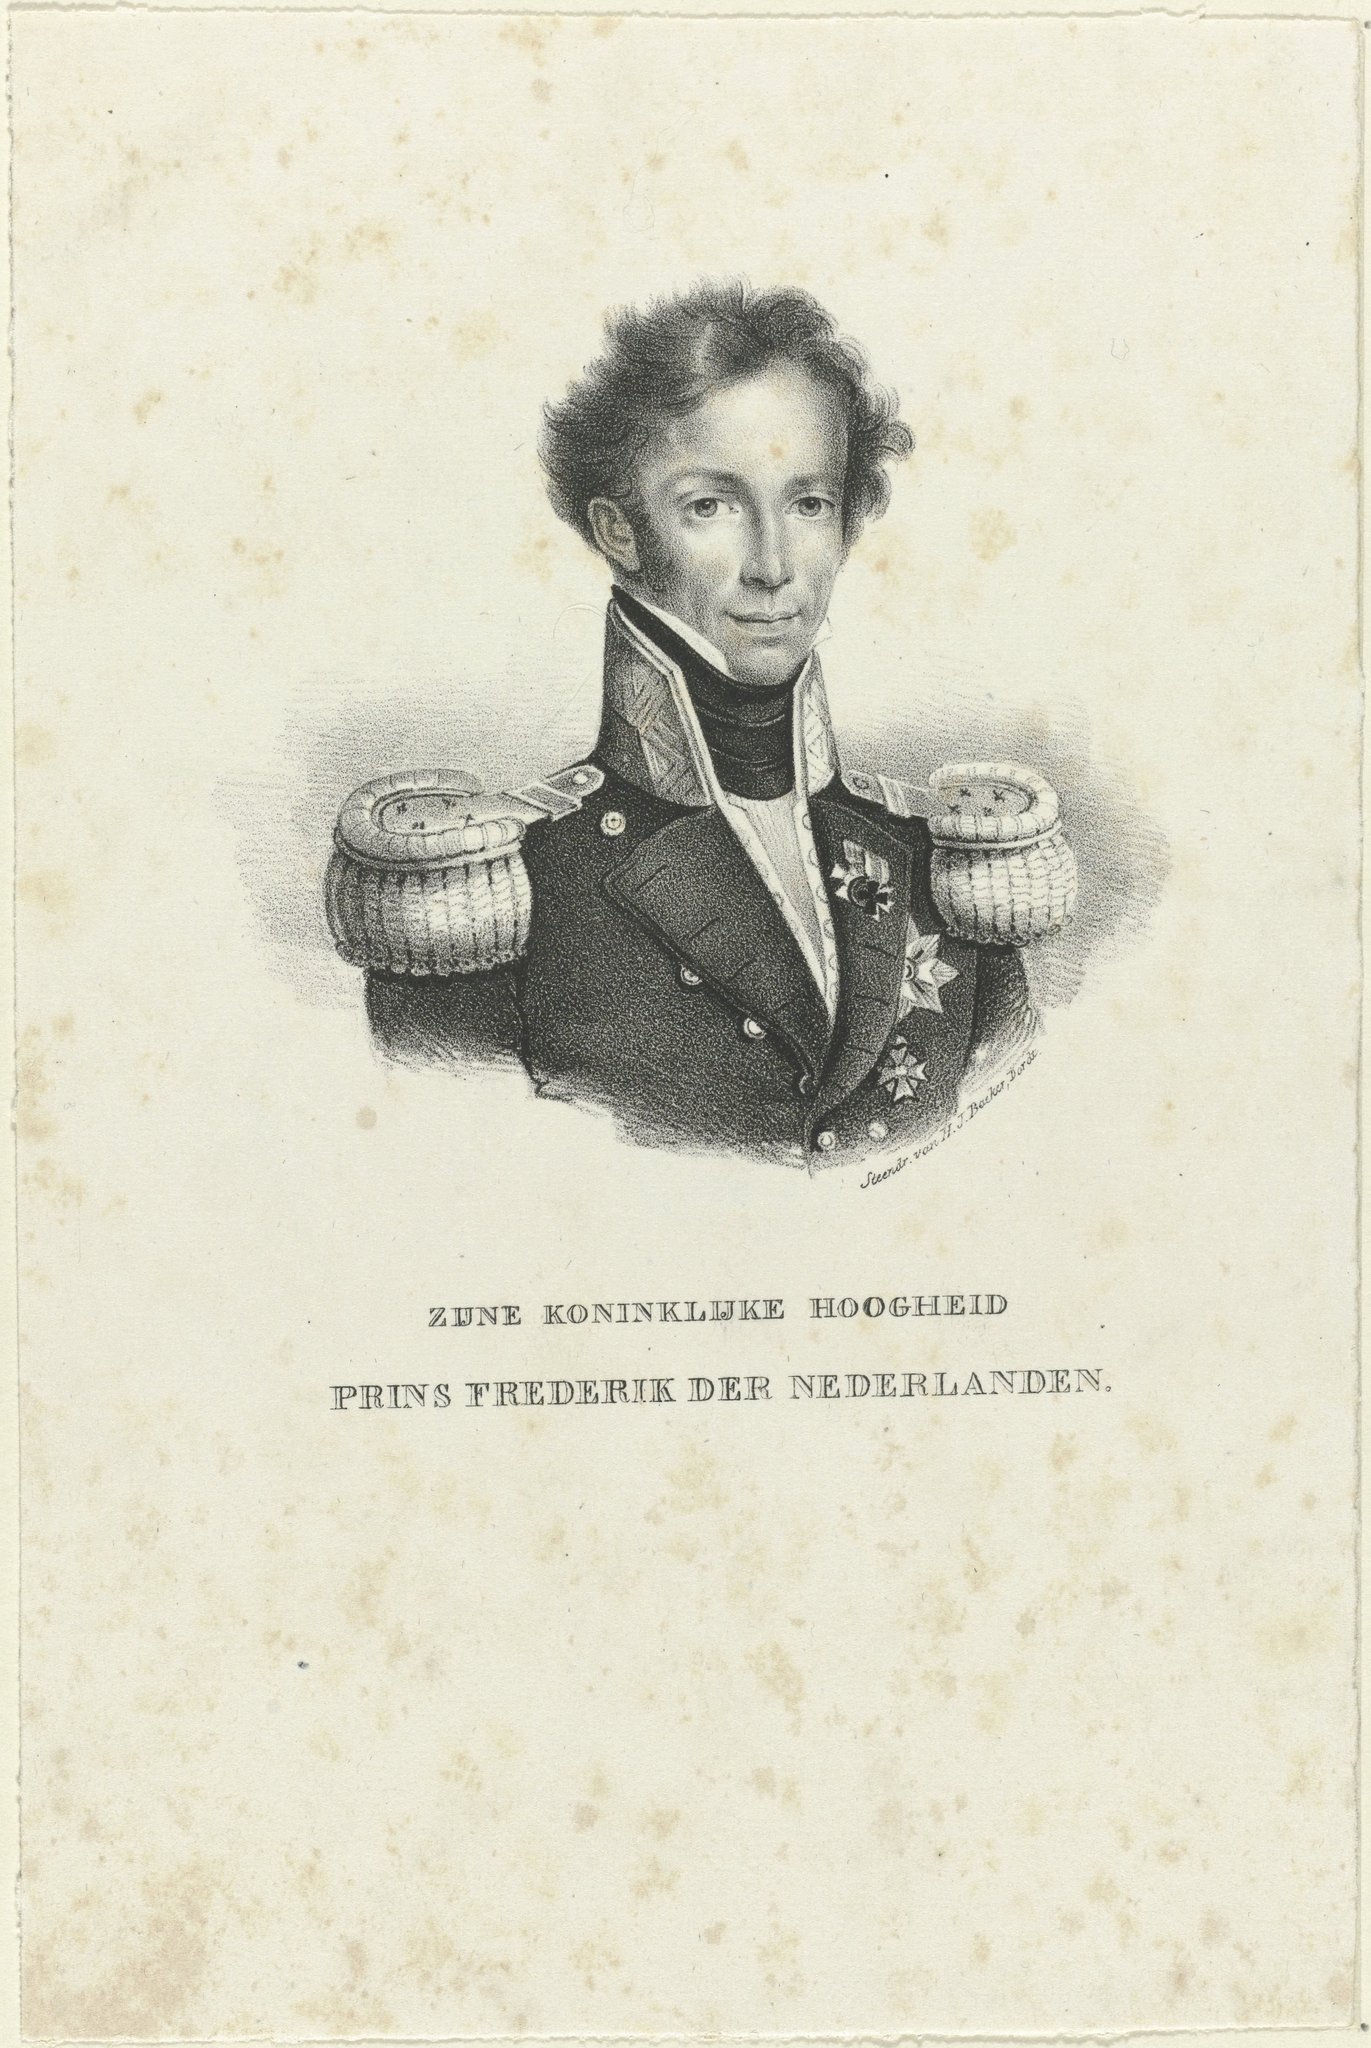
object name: print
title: Portret van Frederik, prins der Nederlanden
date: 1822-1845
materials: paper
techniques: lithograph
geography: dordrecht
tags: berlin, frederik (prins der nederlanden)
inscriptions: collector's mark: Lugt 2228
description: De hier vermelde titel verwijst naar de hoogst verkregen titel van de geportretteerde, niet per se naar de titel die de geportretteerde op deze voorstelling draagt.